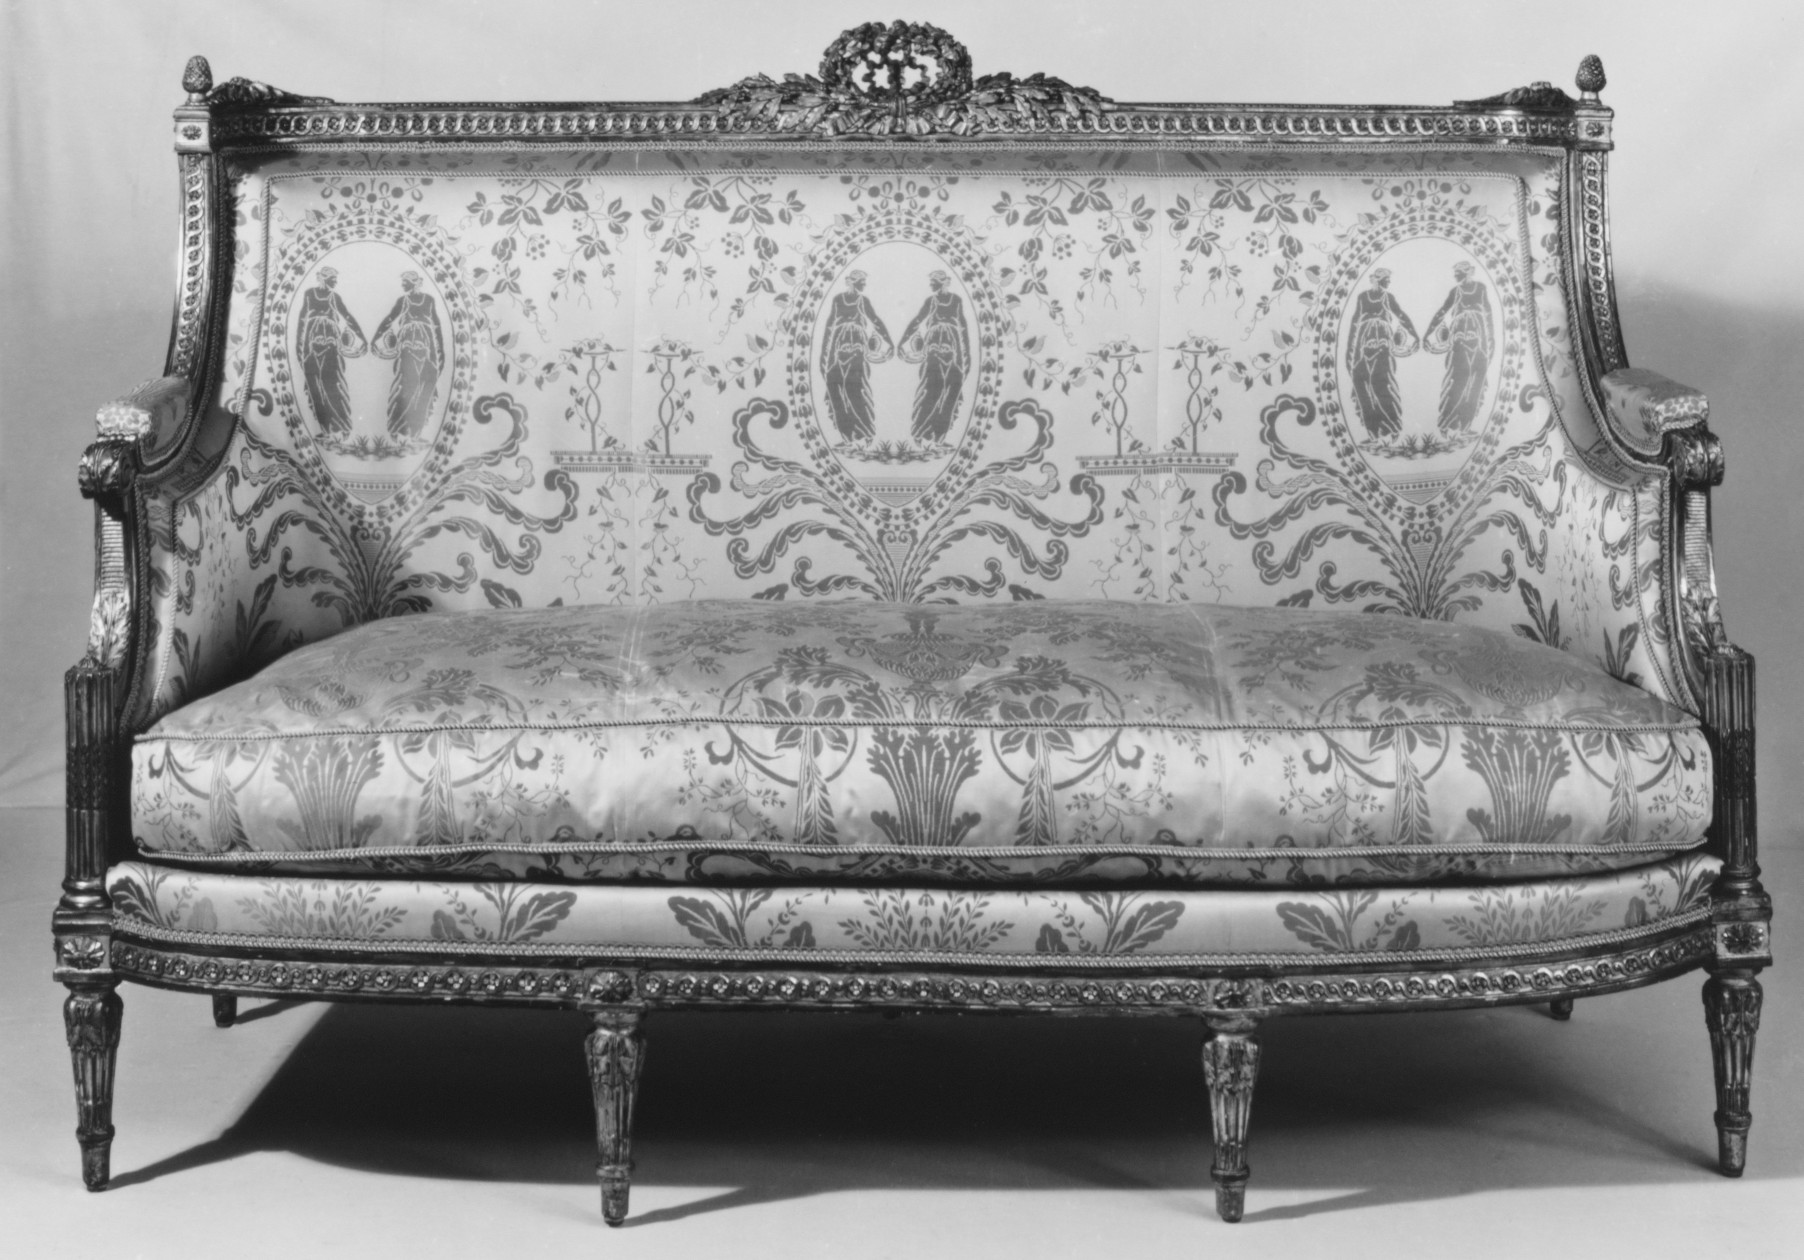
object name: sofa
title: Sofa (part of a set)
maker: jean-baptiste-bernard demay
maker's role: maker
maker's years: 1759-1849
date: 1785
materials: silk, wood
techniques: carving, gilding, lampas